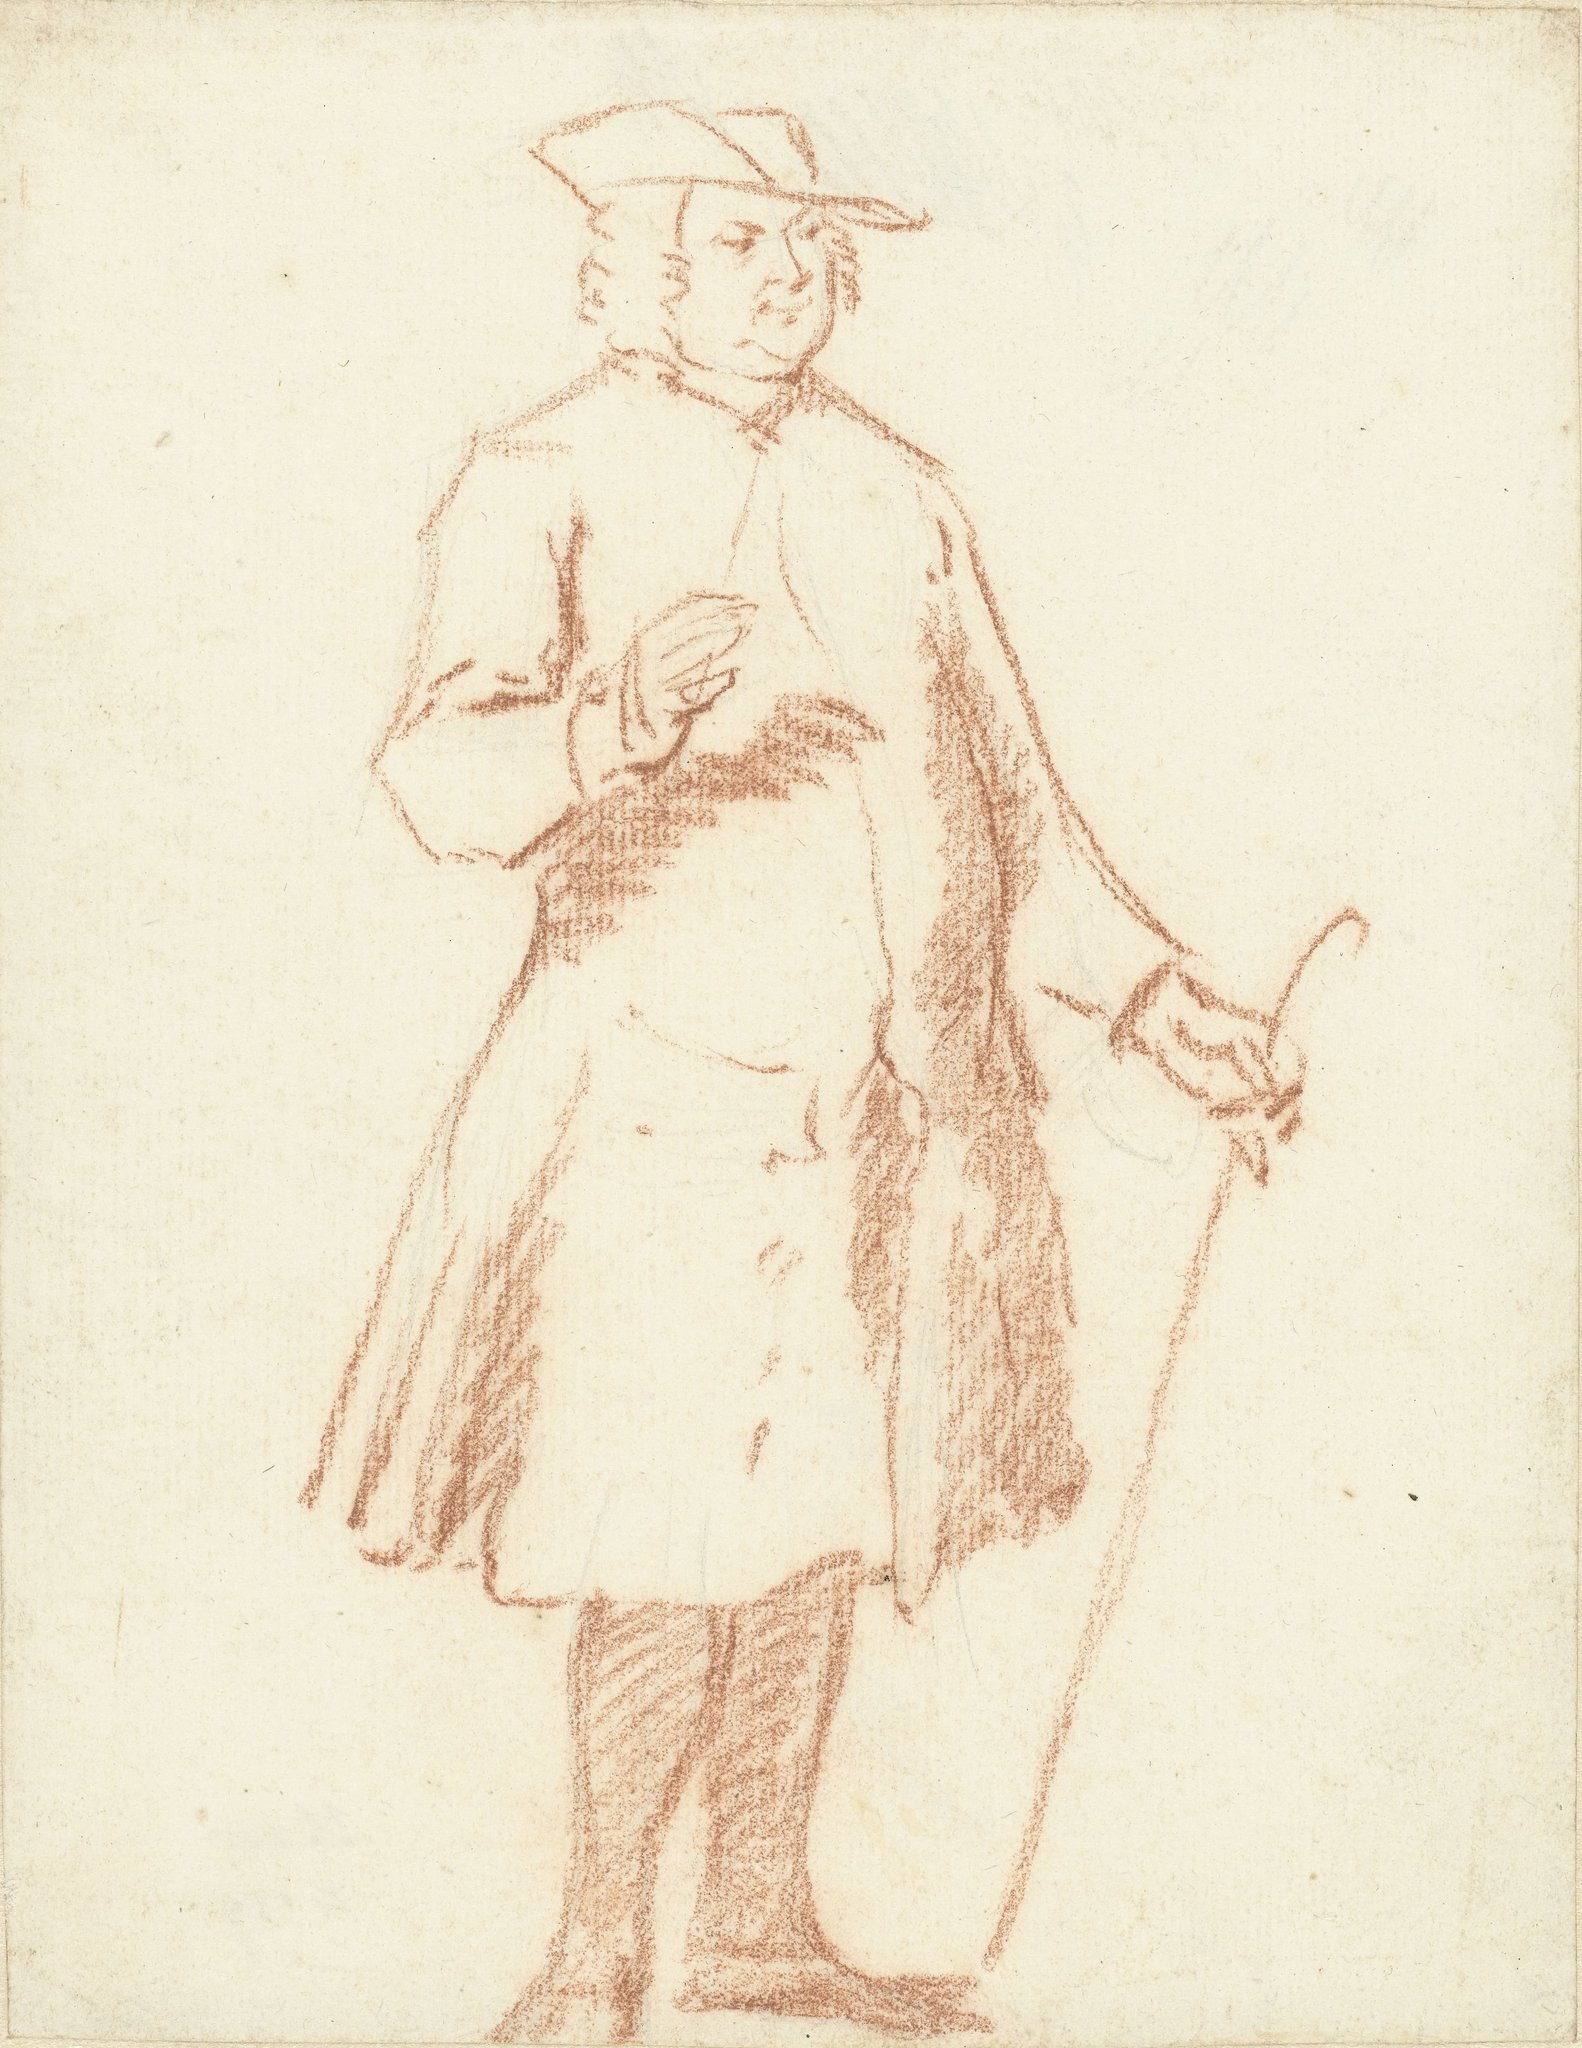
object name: drawing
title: Staande man met wandelstok in de linkerhand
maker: cornelis troost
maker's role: draughtsman, painter, print maker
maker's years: 1696-1750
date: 1706-1750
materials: chalk, paper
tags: postures of the human figure